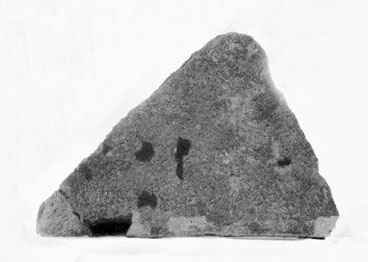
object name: shard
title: Shard (Study Collection)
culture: chinese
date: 1644-1911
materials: amber, ceramic, glaze